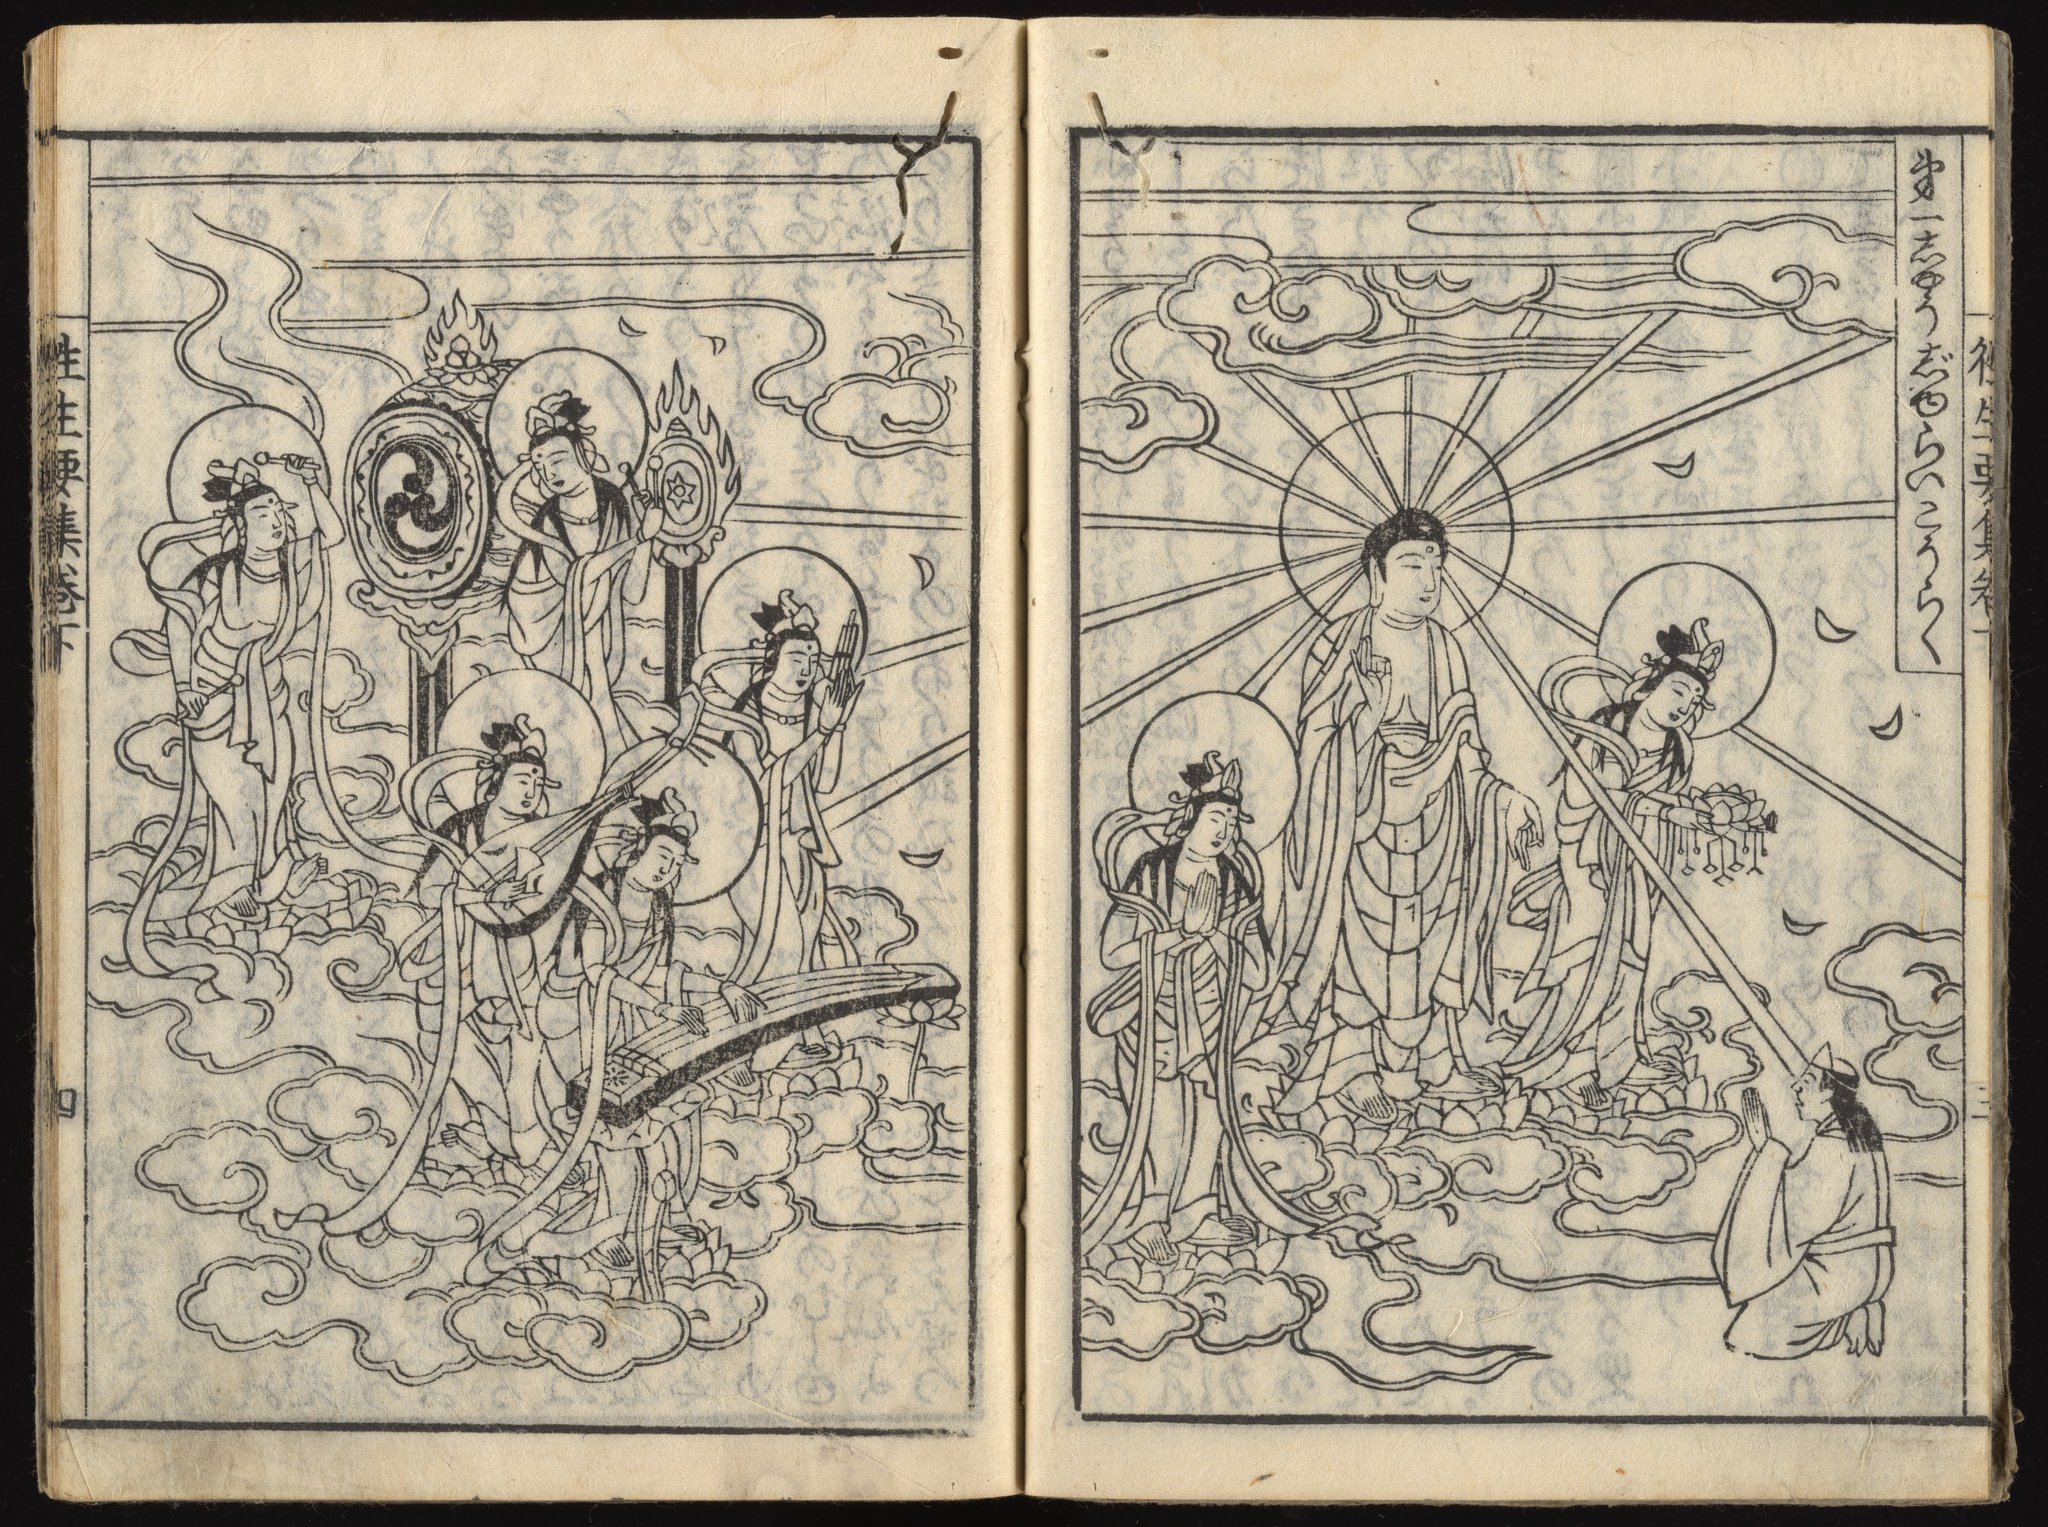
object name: illustrated book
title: The Essentials of Rebirth in the Pure Land (Ojōyōshū)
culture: japanese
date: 1790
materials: ink, paper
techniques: woodblock print